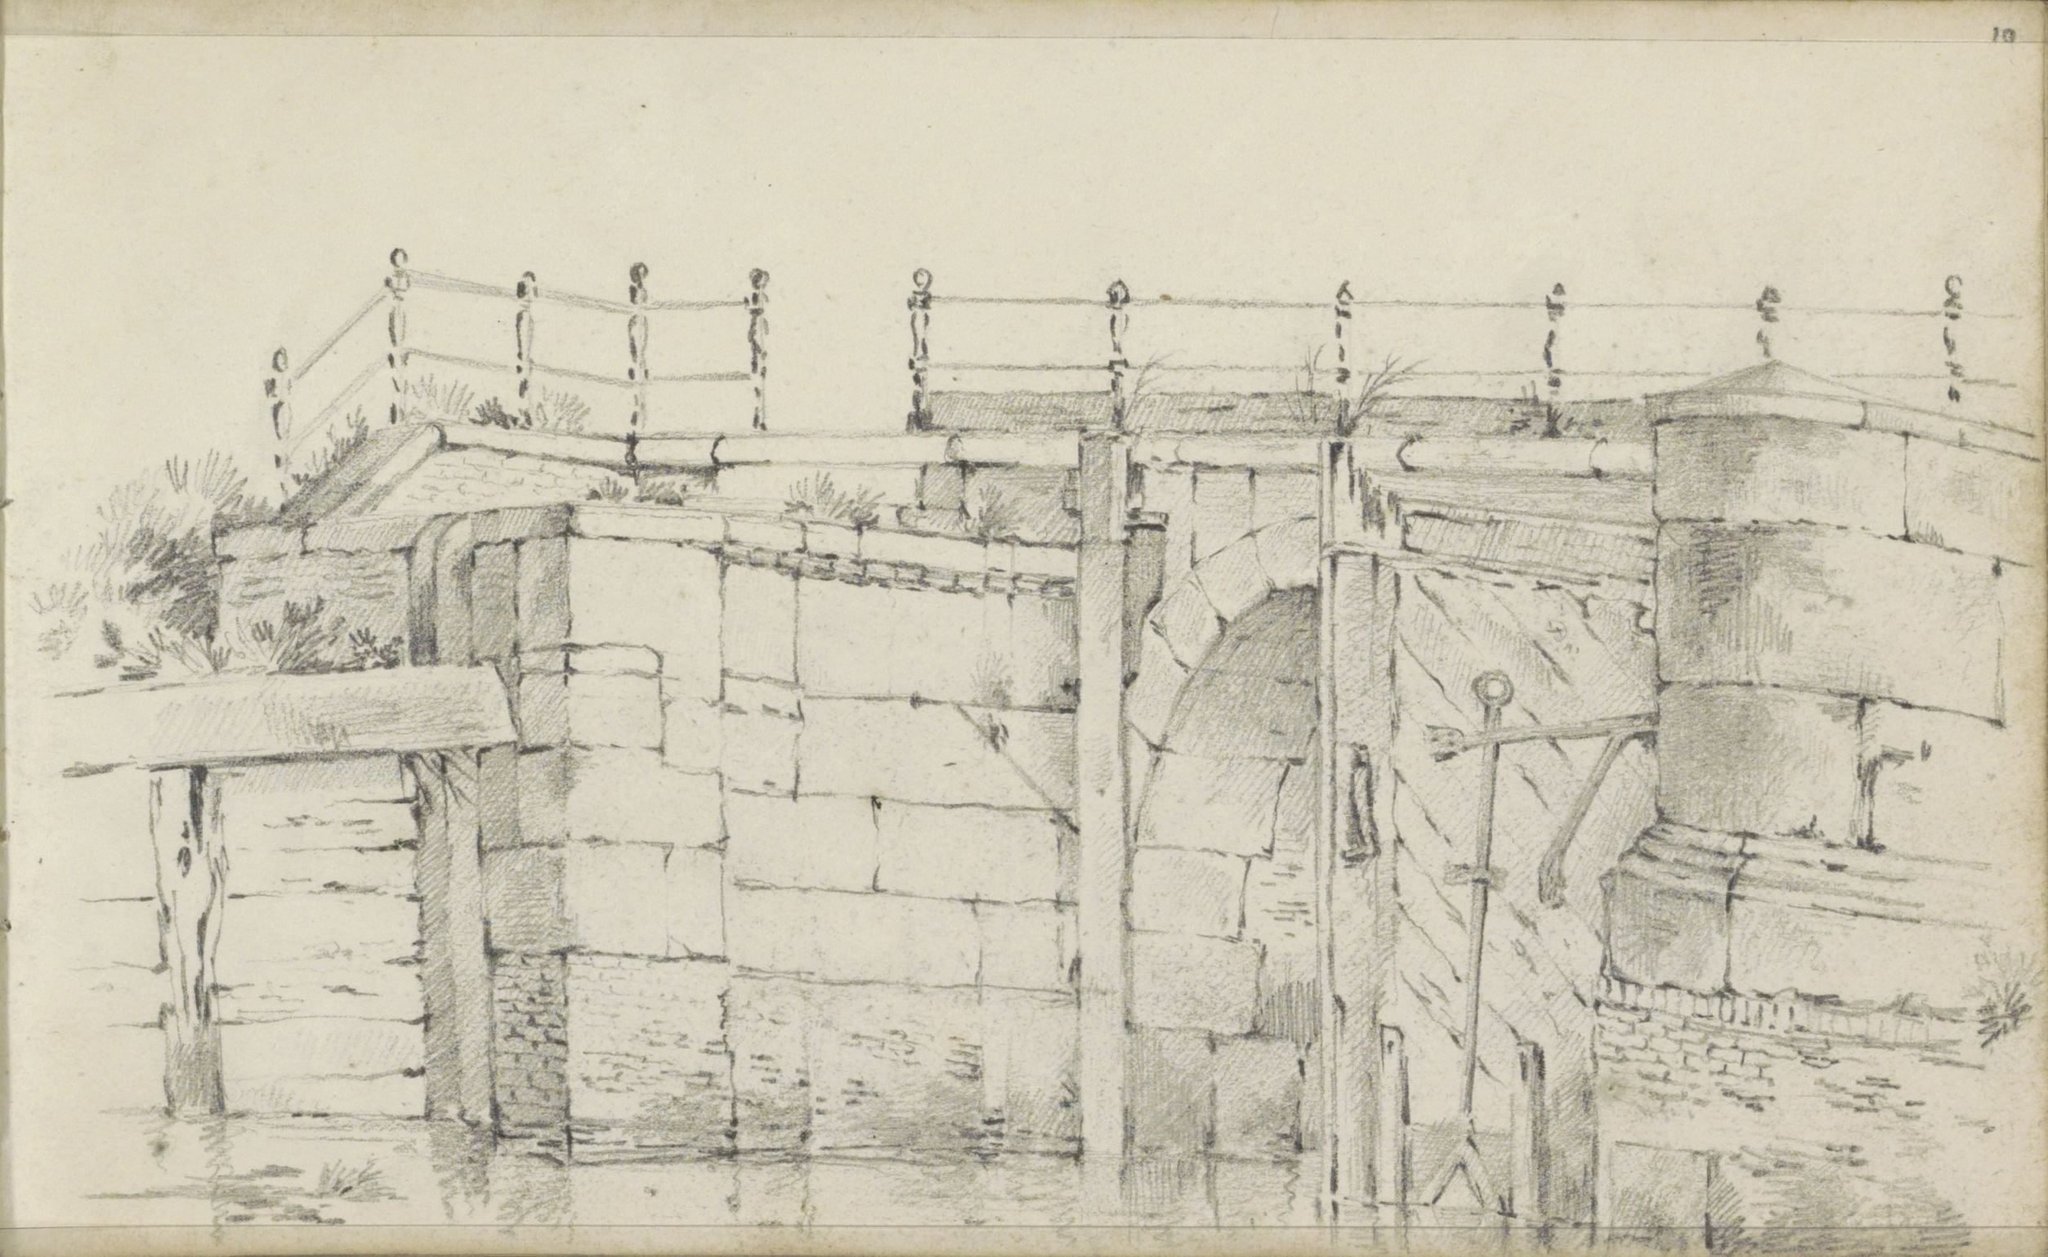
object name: sketchbook leaf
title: Gezicht op een brug of sluis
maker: adrianus eversen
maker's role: draughtsman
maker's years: 1818-1897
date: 1828-1897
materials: paper, pencil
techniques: stumping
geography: netherlands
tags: sluice, weir, village street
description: Gezicht op een brug of sluis. Blad 10 recto uit een schetsboek met 27 bladen.